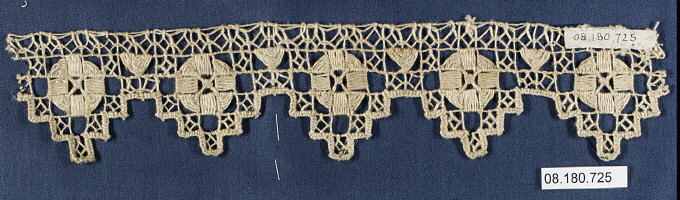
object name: fragment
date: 1801-1900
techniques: embroidery